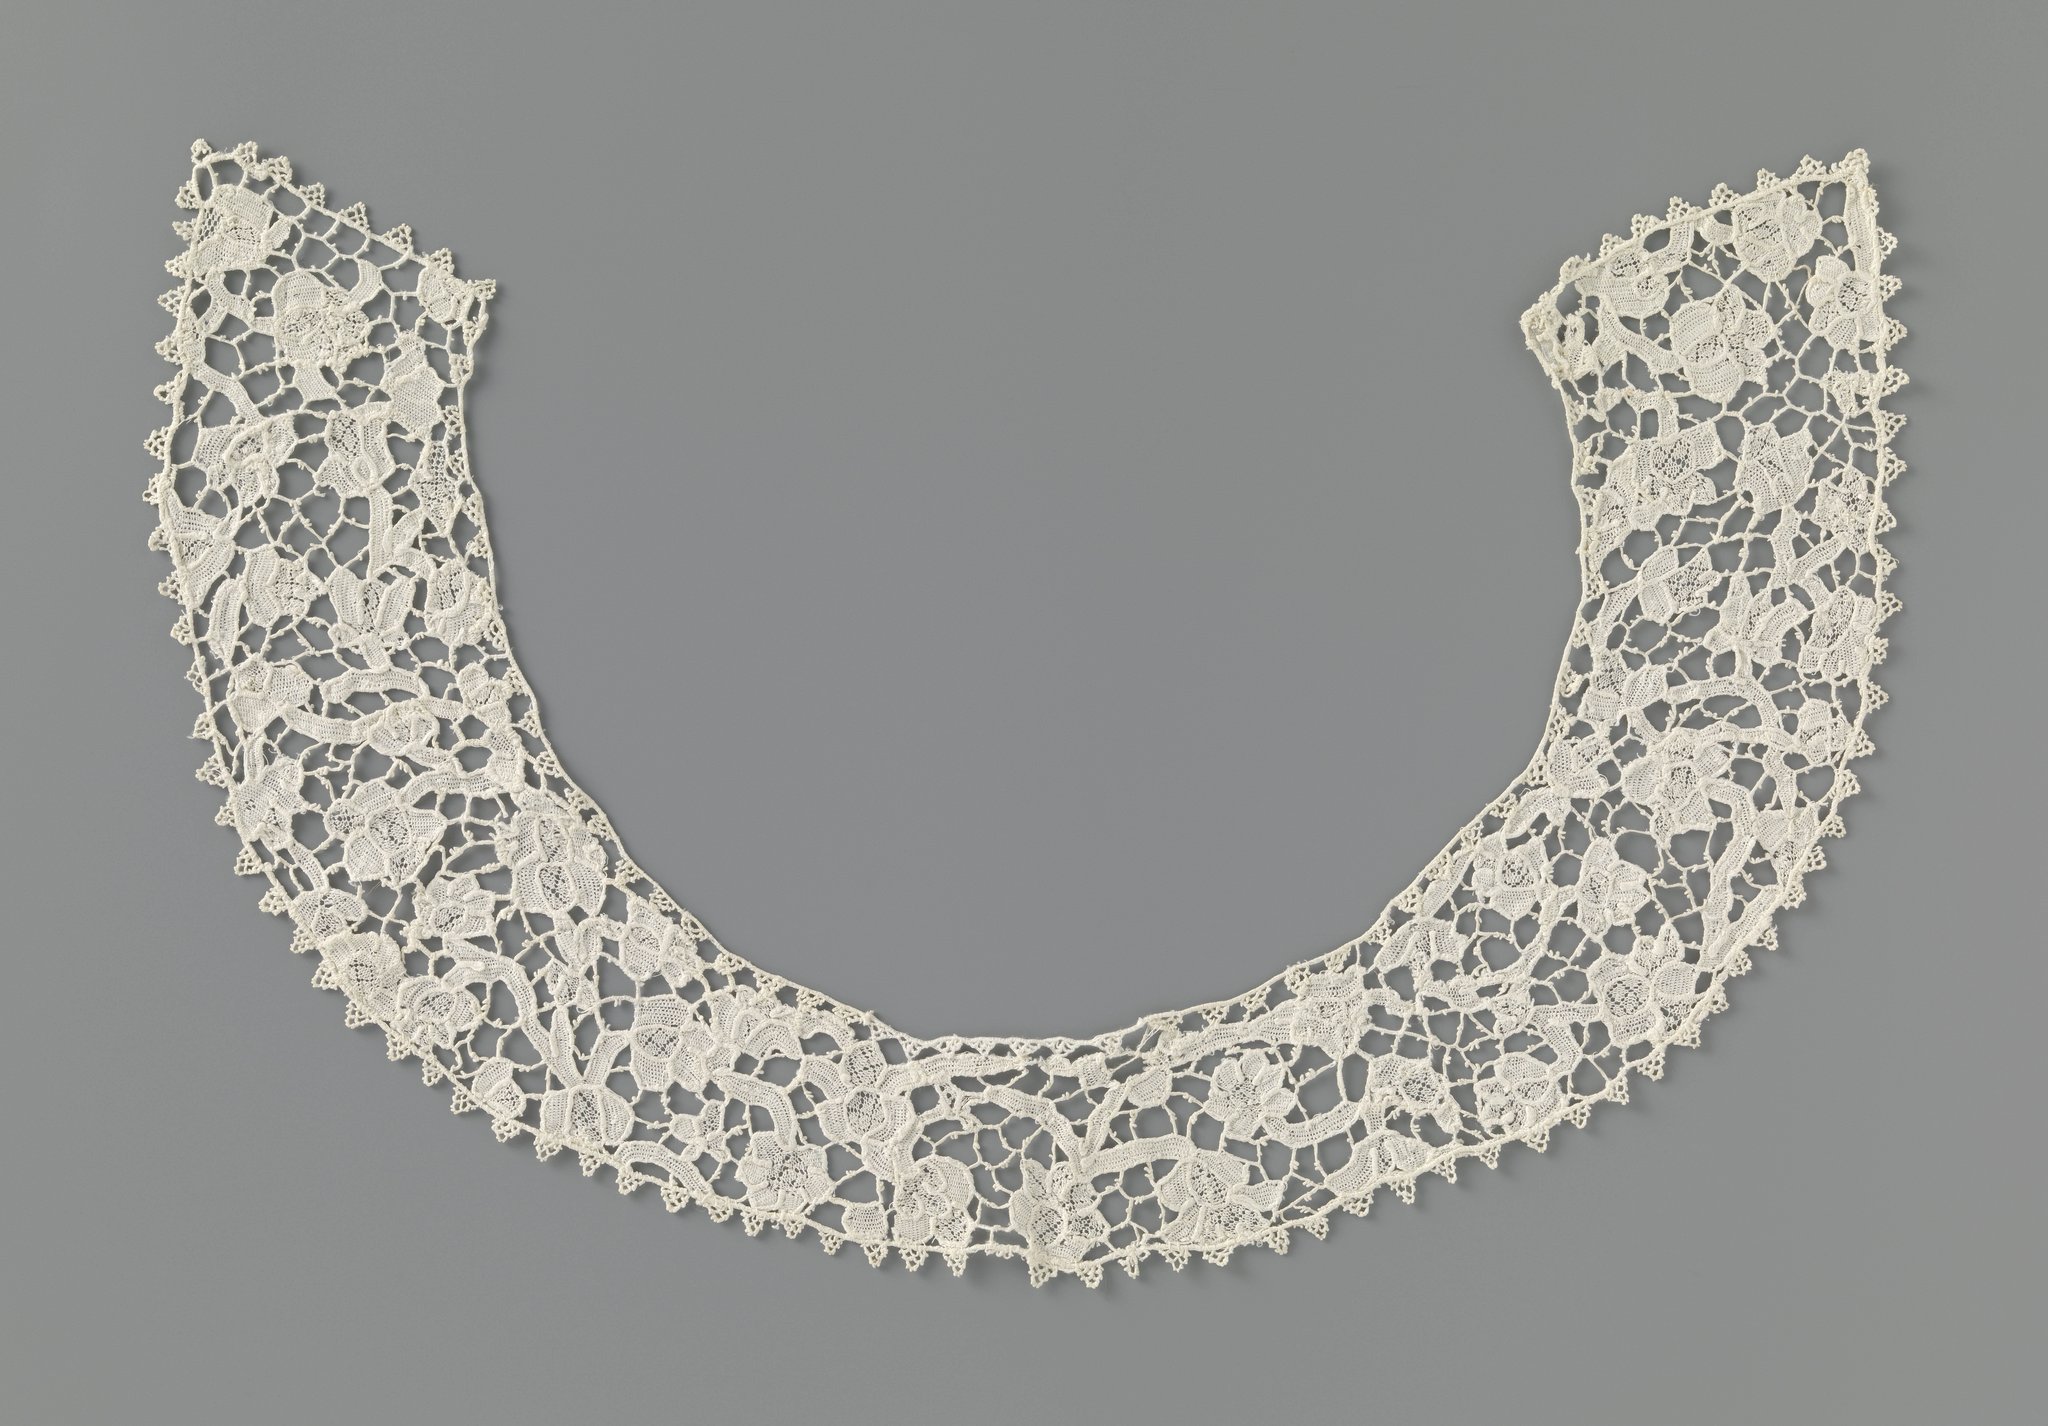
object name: collar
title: Rond kraagje met vele bloemen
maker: Anonymous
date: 1670-1680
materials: linen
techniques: flat venetian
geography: venice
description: Kraag van naturelkleurige naaldkant: platte Venetiaanse kant. Op een open spijlengrond staan grove ranken en bloemen. Boogjesrand van gelijke driehoekjes. Versneden en vernaaid tot een ronde vorm.